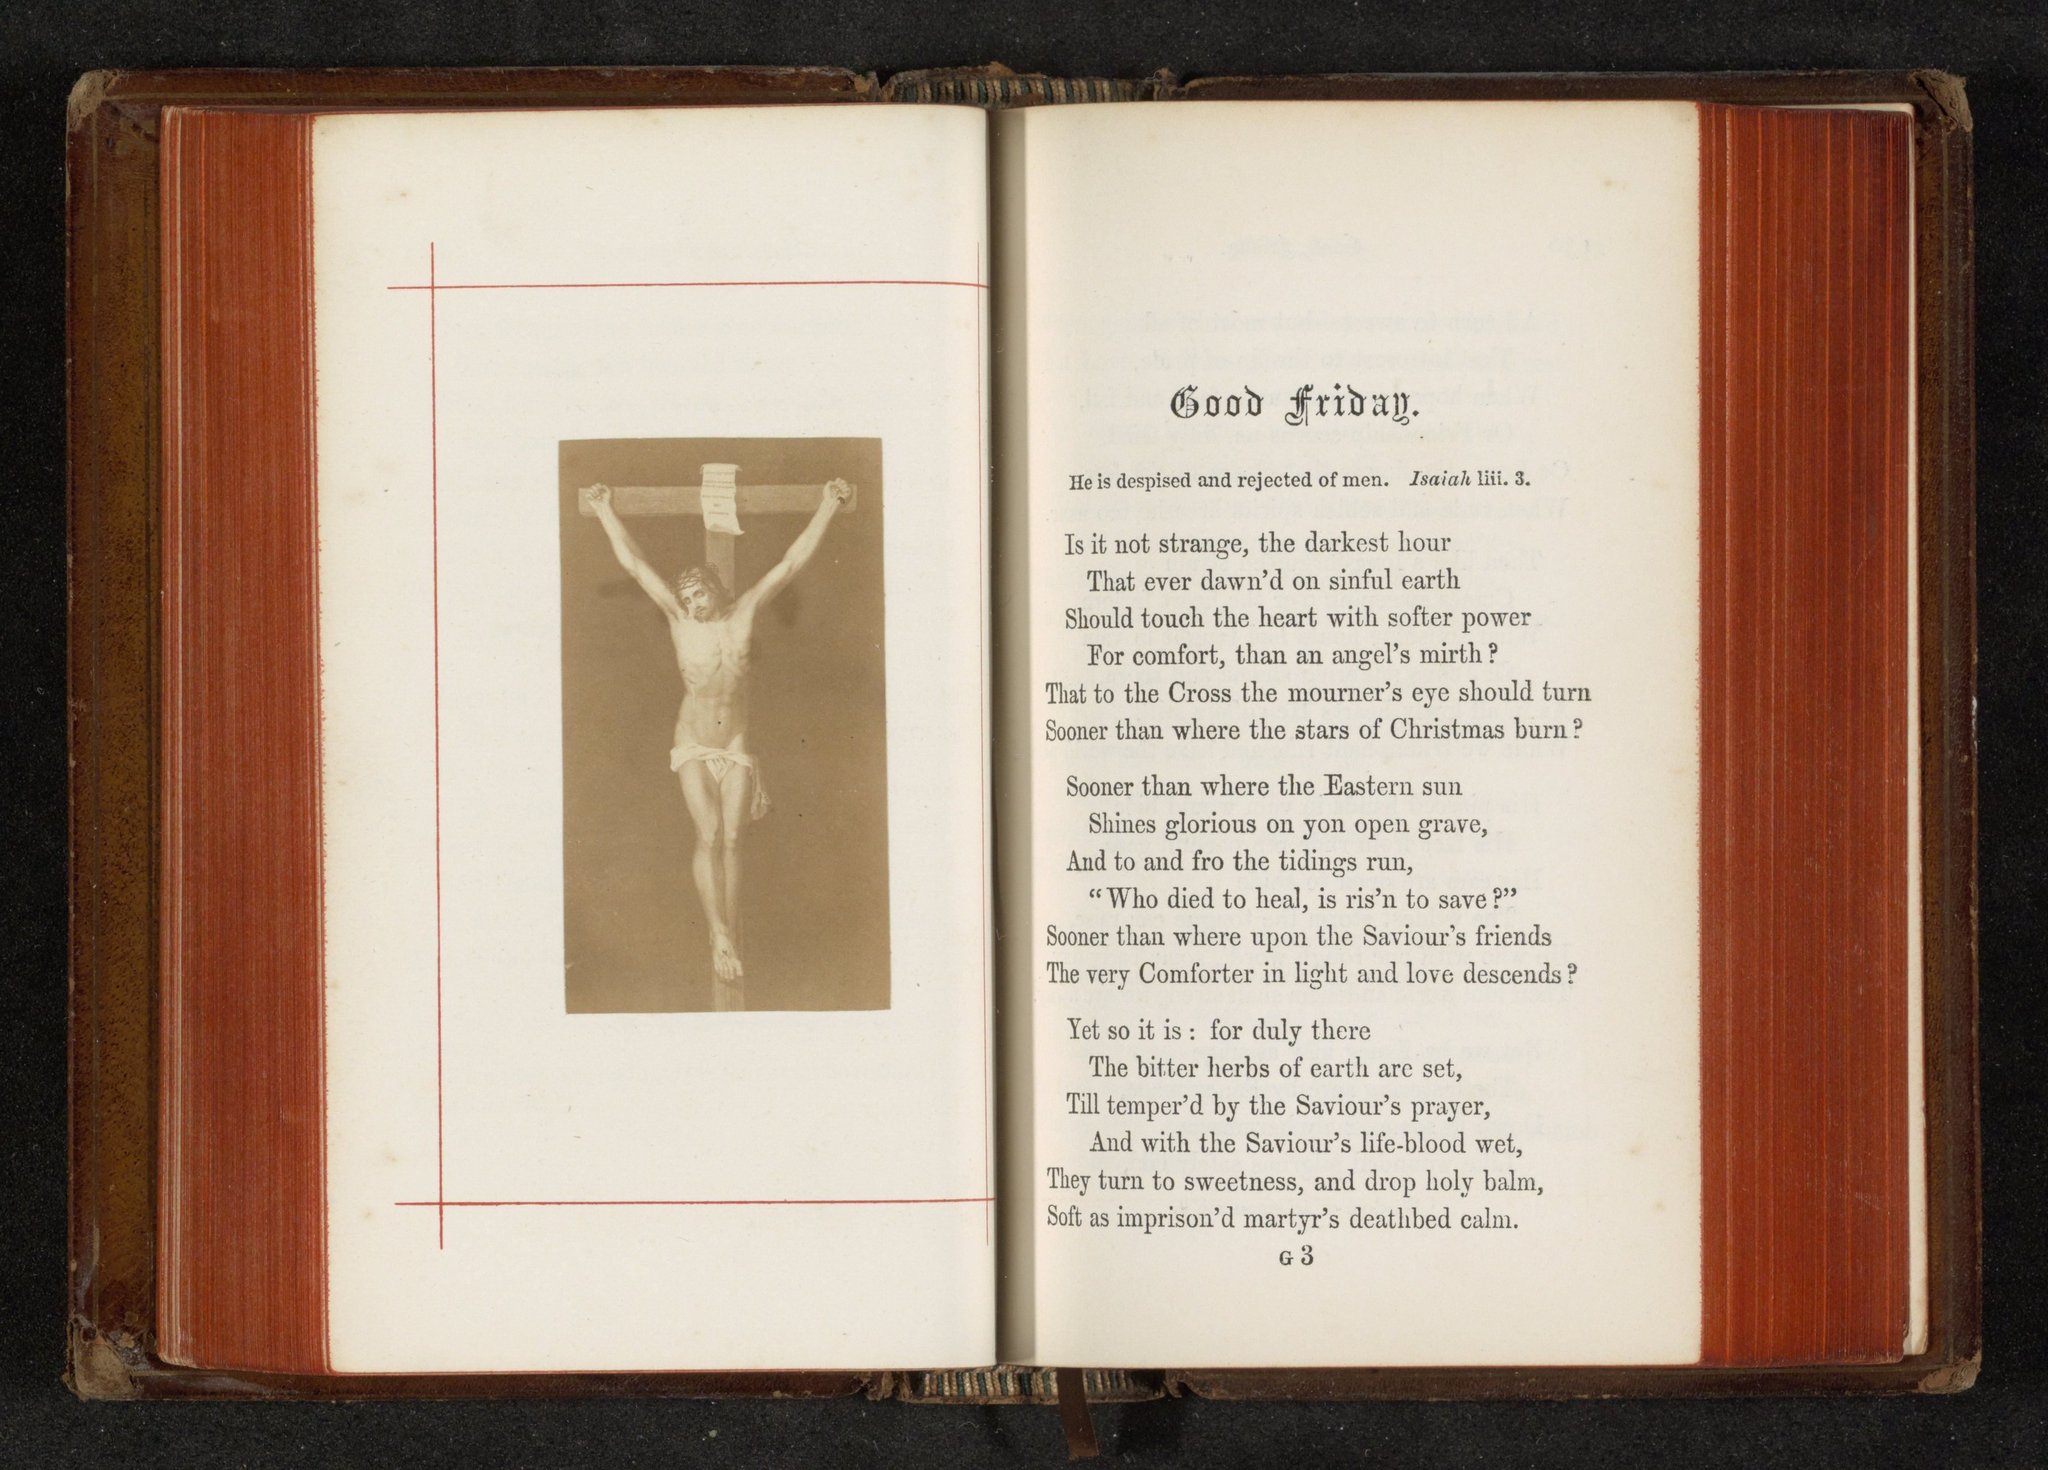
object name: page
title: Fotoreproductie van een prent, voorstellende de kruisiging van Christus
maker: Anonymous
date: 1865-1870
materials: photographic support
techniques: albumen print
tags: the crucifixion of christ: christ's death on the cross; golgotha (matthew 27:45-58; mark 15:33-45; luke 23:44-52; john 19:25-38)